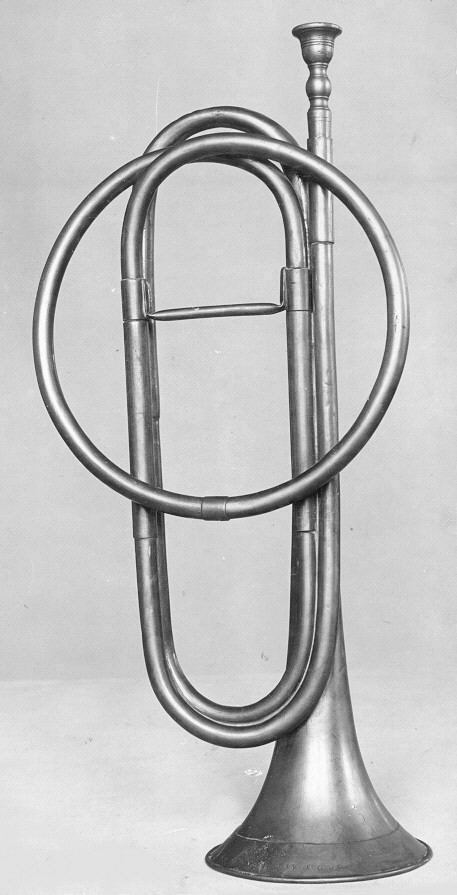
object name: cavalry trumpet in c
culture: french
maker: courtois père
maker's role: maker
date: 1800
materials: brass, nickel, silver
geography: france